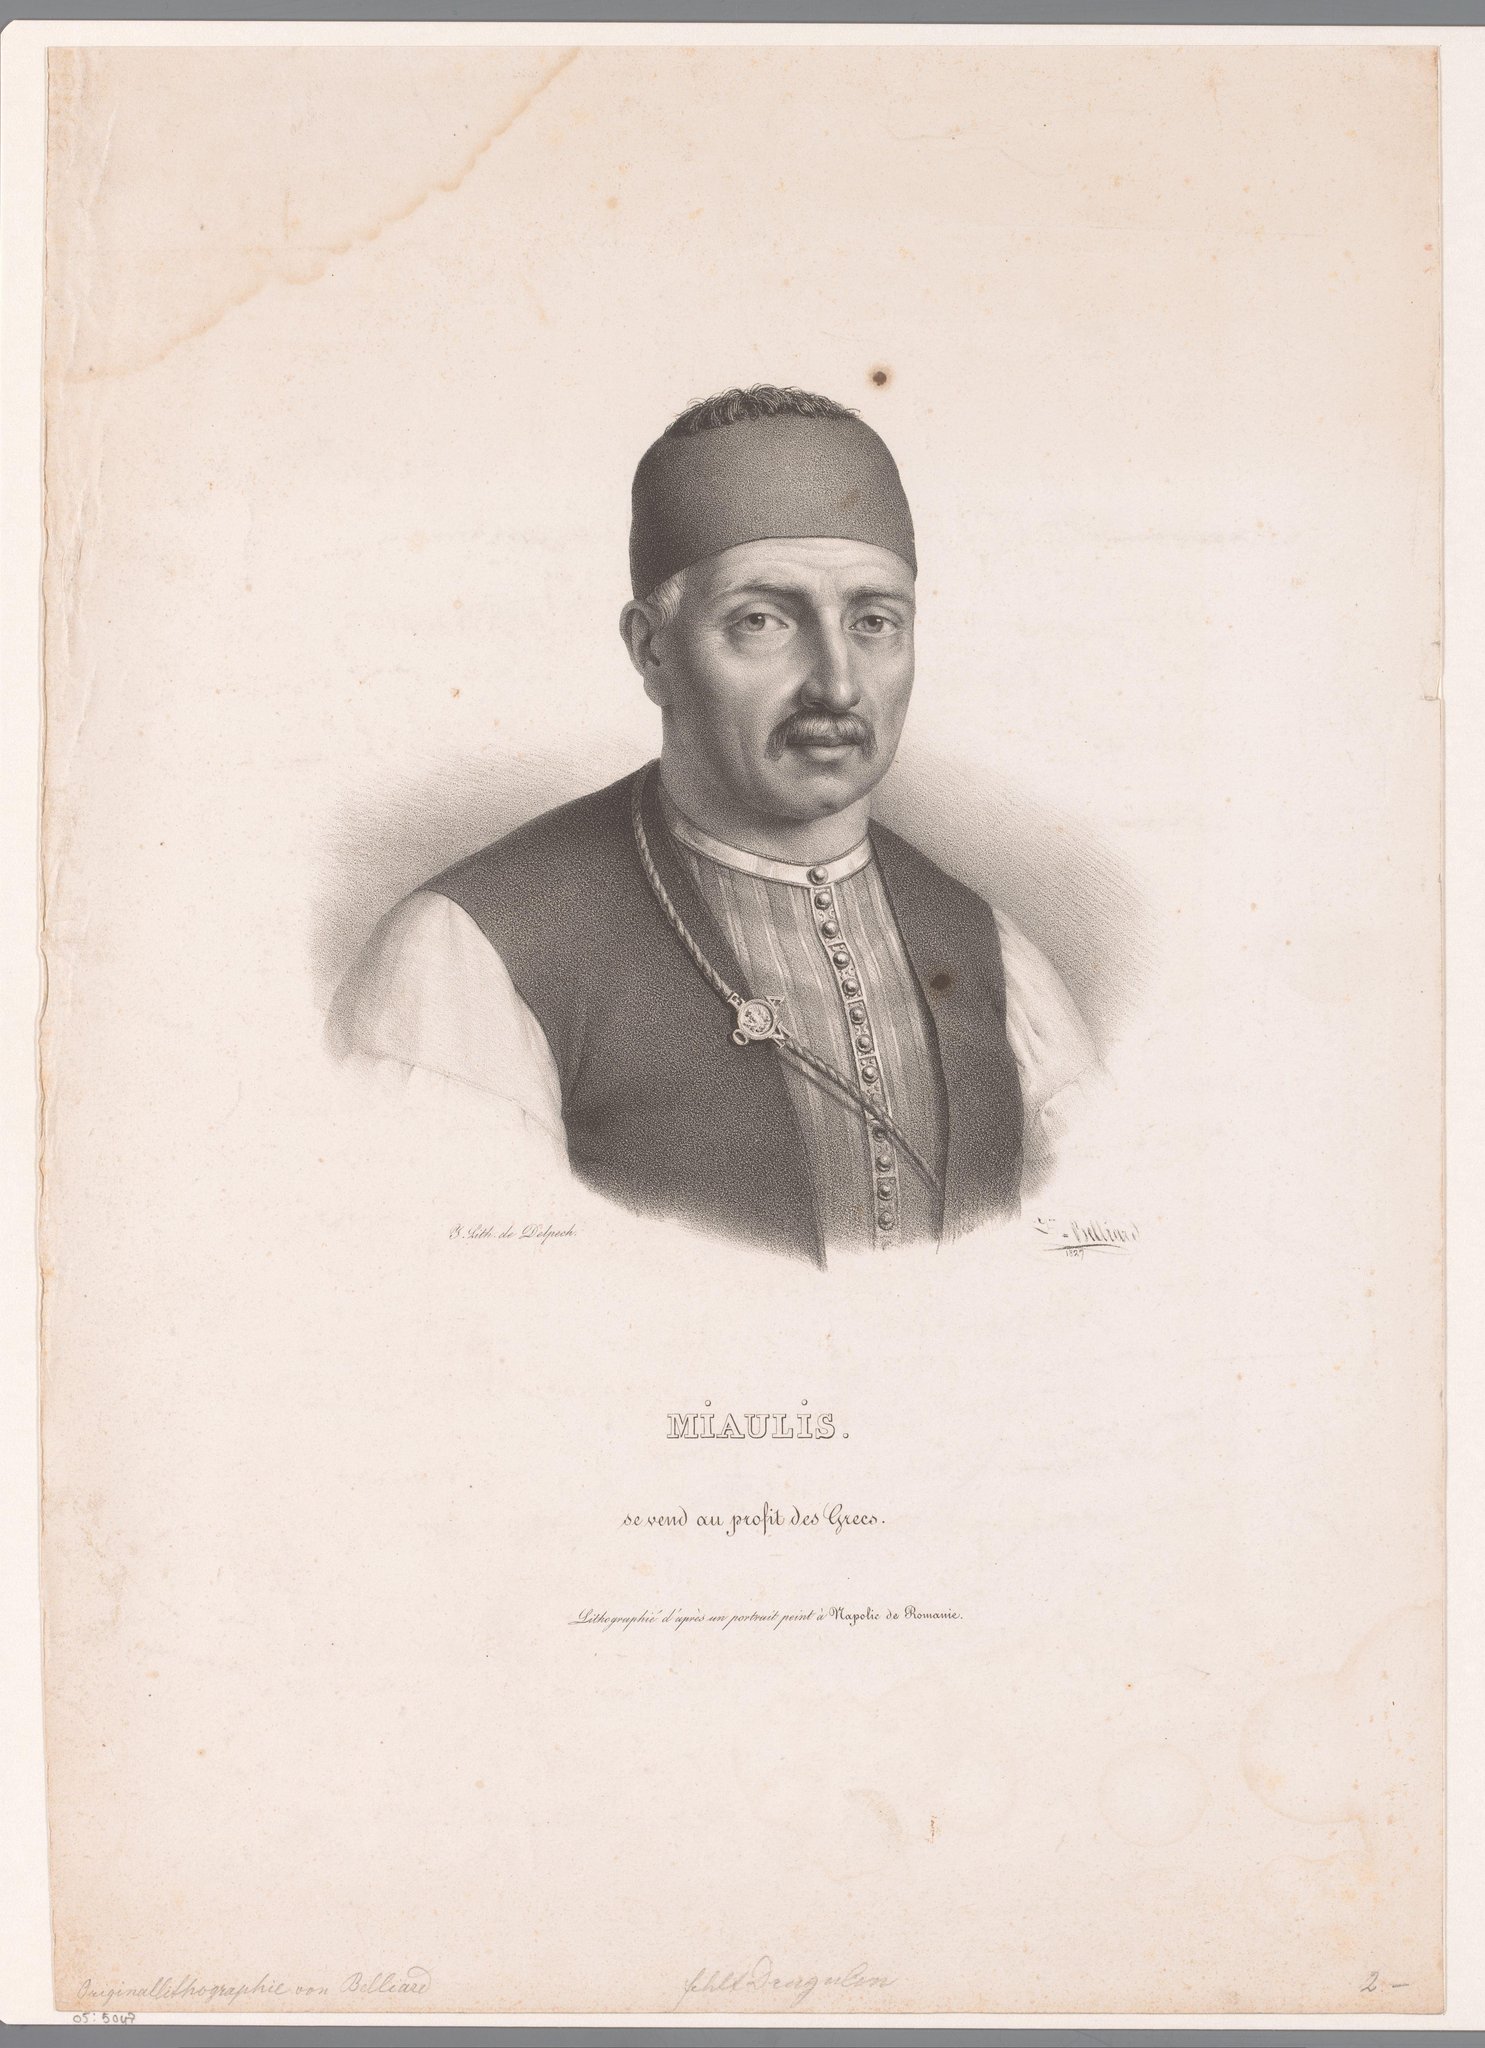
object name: print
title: Portret van Andreas Miaoulis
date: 1827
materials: paper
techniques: lithograph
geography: paris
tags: politician, moustache, adult man, historical persons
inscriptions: collector's mark: Lugt 2228